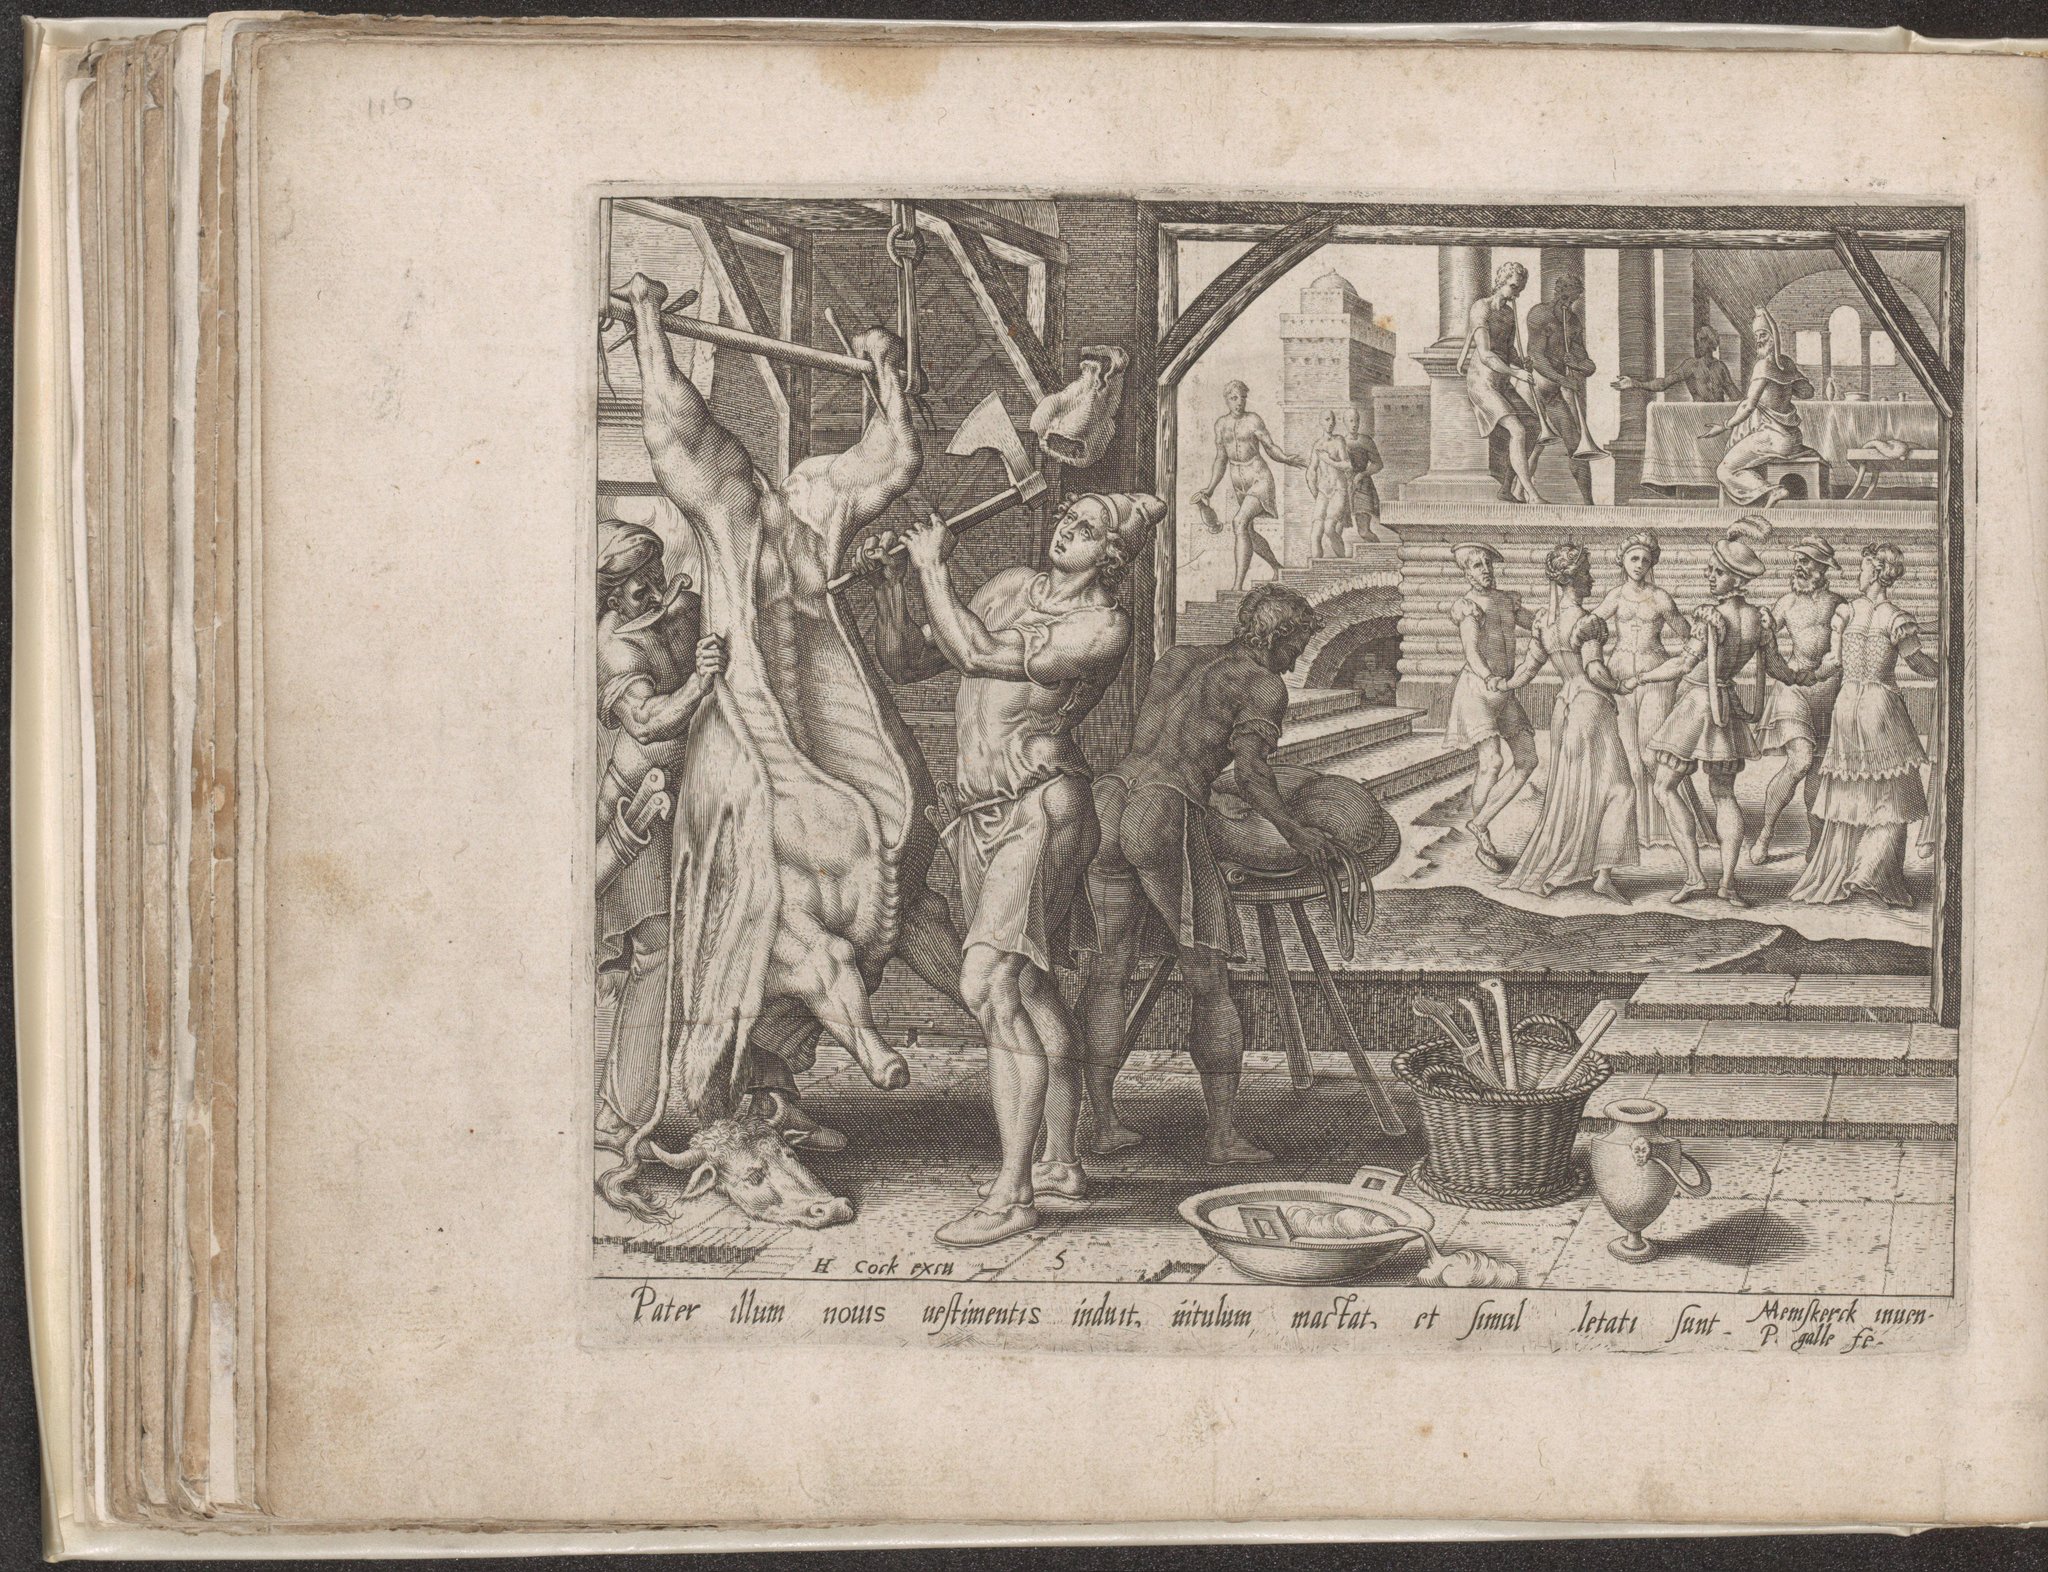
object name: print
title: Het vetgemeste kalf wordt geslacht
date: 1562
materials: paper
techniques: engraving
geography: antwerp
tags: preparations, e.g. the prodigal son is given new robes; slaughtering of the fatted calf; the elder son objects, festive reception of the prodigal son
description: Ter ere van de thuiskomst van de verloren zoon wordt een vetgemest kalf geslacht. Op de binnenplaats danst de verloren zoon met de gasten. Een lange tafel staat klaar voor het feestmaal. Onder de voorstelling een verklarende tekst in het Latijn. Deze prent maakt deel uit van een album.